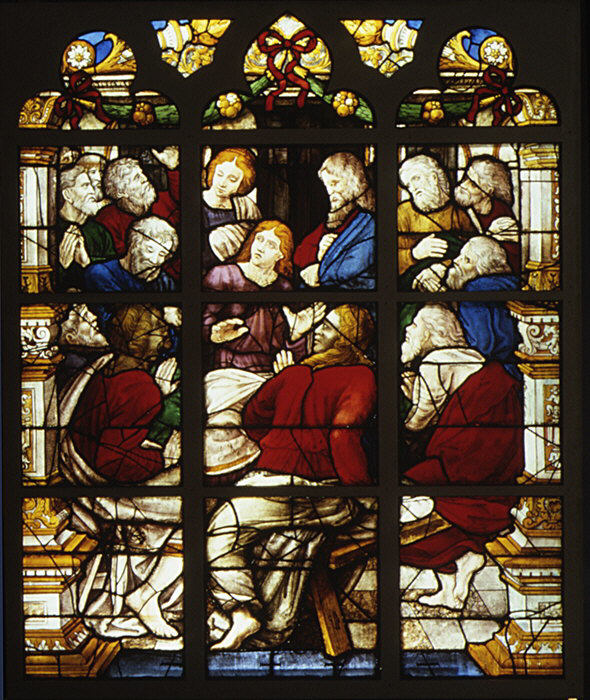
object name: window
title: The Disciples in the Upper Room (?)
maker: pieter coecke van aelst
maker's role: designer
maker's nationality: netherlandish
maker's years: 1502-1550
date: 1535-1550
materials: glass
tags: men,women